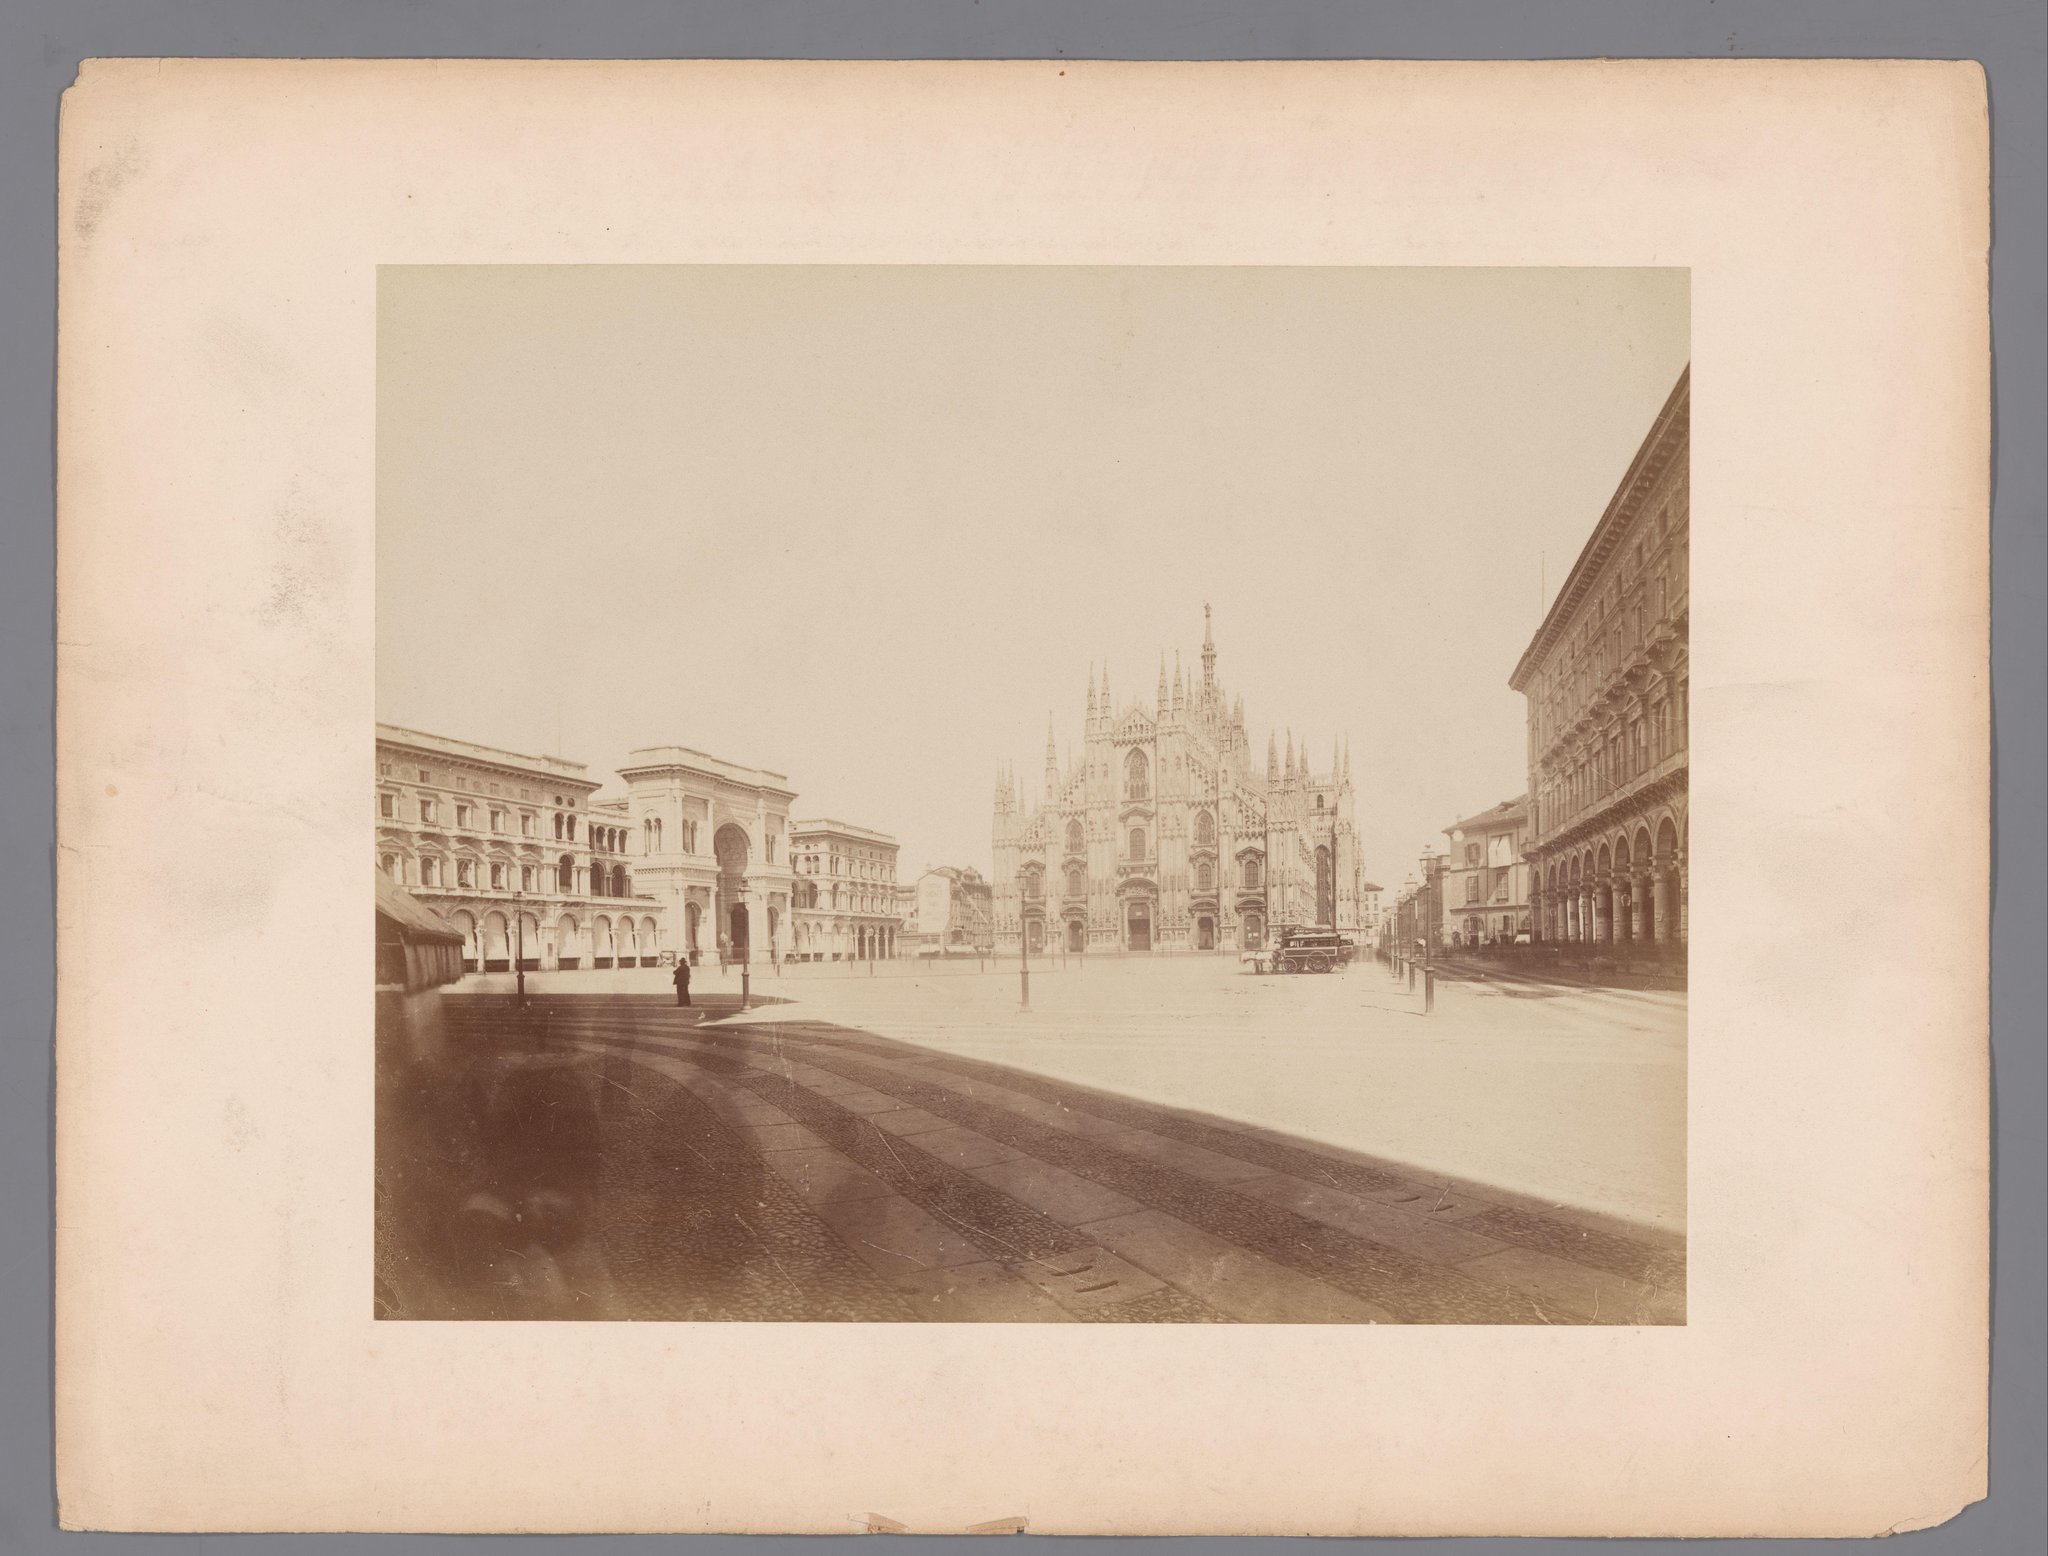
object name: photograph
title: Gezicht op de kathedraal van Milaan en de Galleria Vittorio Emanuele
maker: Anonymous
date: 1878-1900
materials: cardboard, paper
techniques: albumen print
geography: milan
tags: square, place, circus, etc., church (exterior), exterior ~ representation of a building